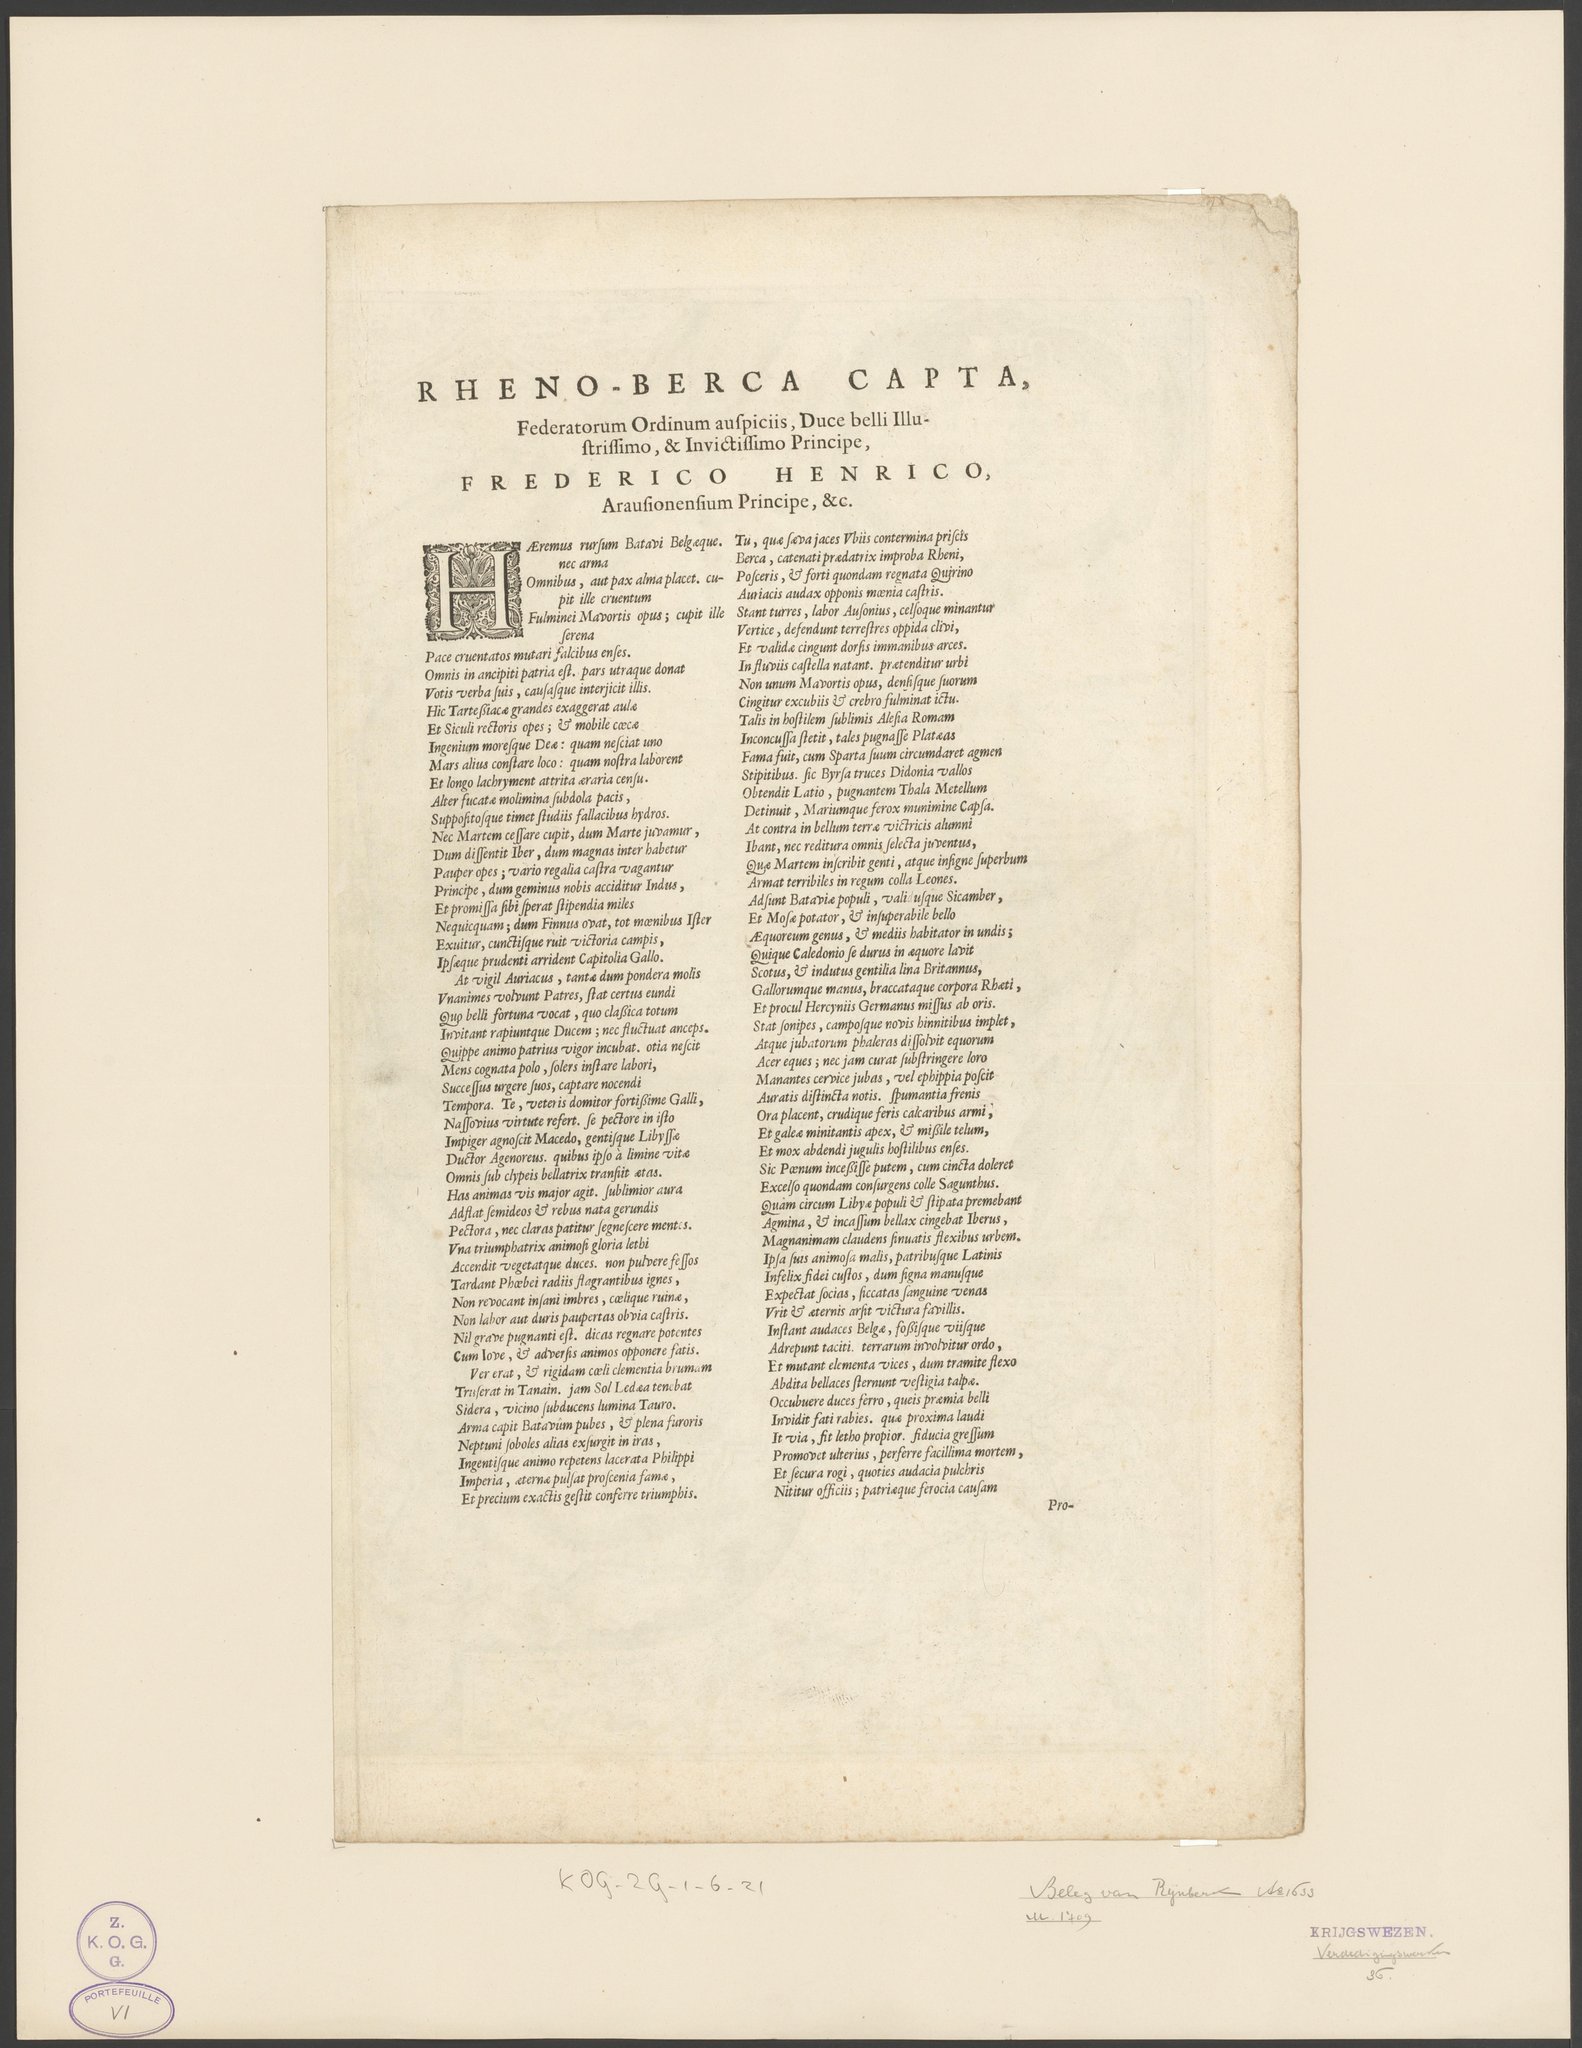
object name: print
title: Obsidio Rhinbercae ad vivum expressa (...) Frederici Henrici Nassovii Principis Auraici opera celebris et ingeniosi Artificis Petri Manteau et Jacobi Culen-burgh Anno 1633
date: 1647-1649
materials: paper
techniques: engraving, etching, letterpress printing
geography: amsterdam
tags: fortress, siege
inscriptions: stamp, stamp, collector's mark: Lugt 1641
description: Kaart van het beleg en de verovering van Rijnberg door het Staatse leger onder Frederik Hendrik, 16 mei - 2 juni 1633. Centraal de stad Rijnberg aan de Rijn, onderaan het kwartier van de stadhouder. Rechtsboven een banderol met de legenda 1-20 in het Nederlands. Linksonder een inzet met een kaartje van het gebied tussen Rijnberg en Maastricht met randwerk met vissers. Op een dubbelblad genomen uit het Stedenboek van Blaeu. Bedrukt op achterzijde met tekst in het Latijn. Onderwerpsrubrieken binnen de Atlas Zeden en Gewoonten: Krijgswezen, Verdedigingswerken.